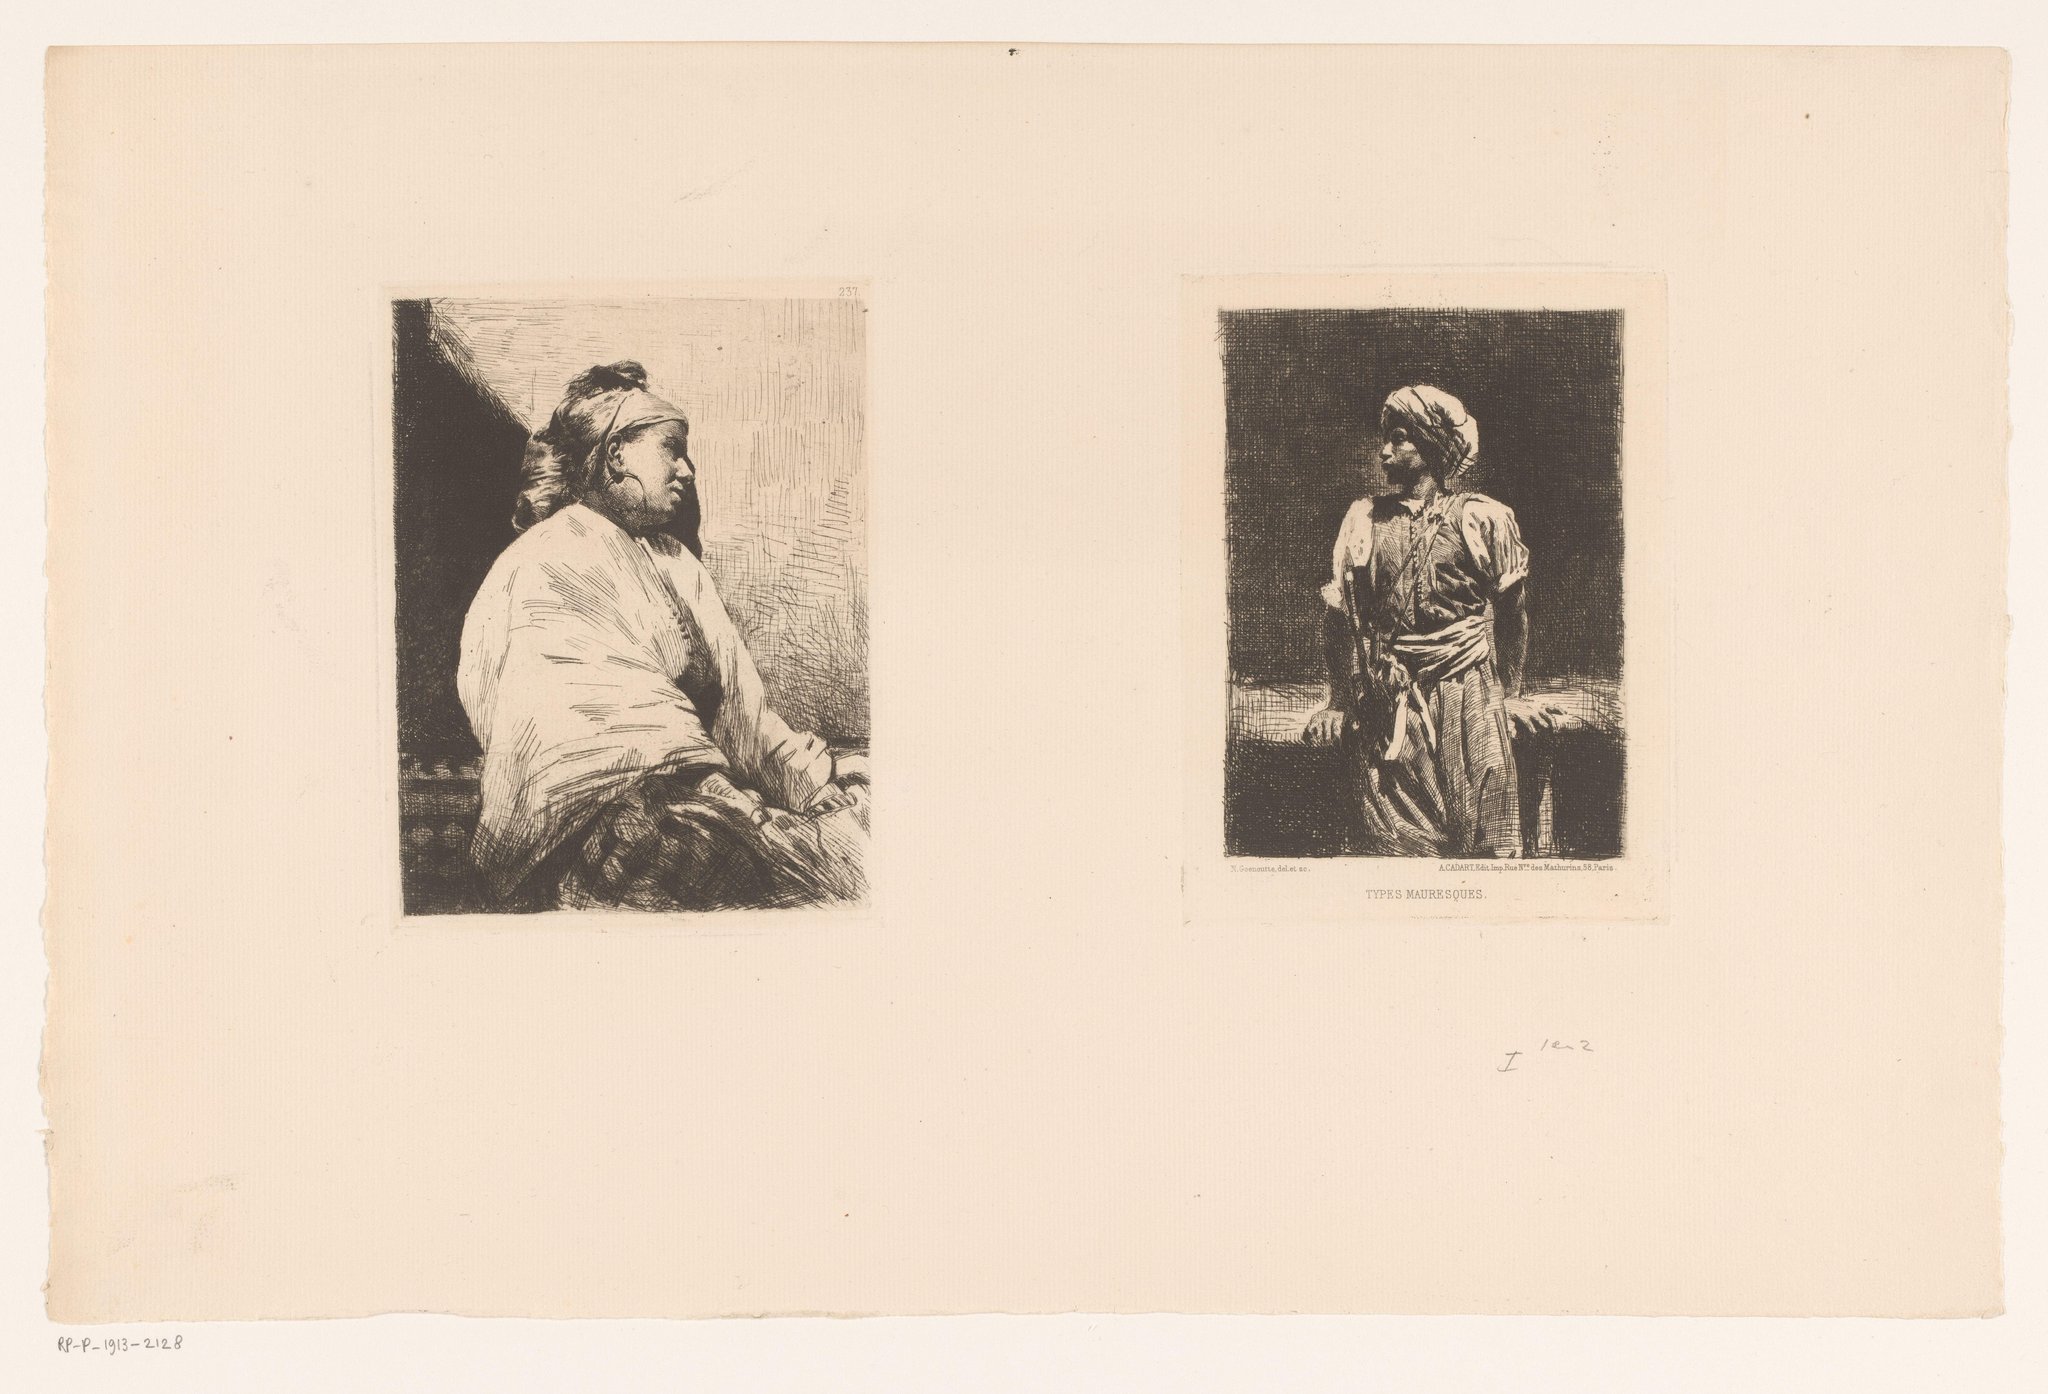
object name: print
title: Moorsch meisje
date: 1874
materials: paper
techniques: etching, intaglio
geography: paris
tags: sitting figure - aa - female human figure, head-gear: turban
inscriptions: collector's mark: Lugt 2233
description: Twee etsen op een niet versneden blad. Genummerd rechtsboven op linker plaat: 237.